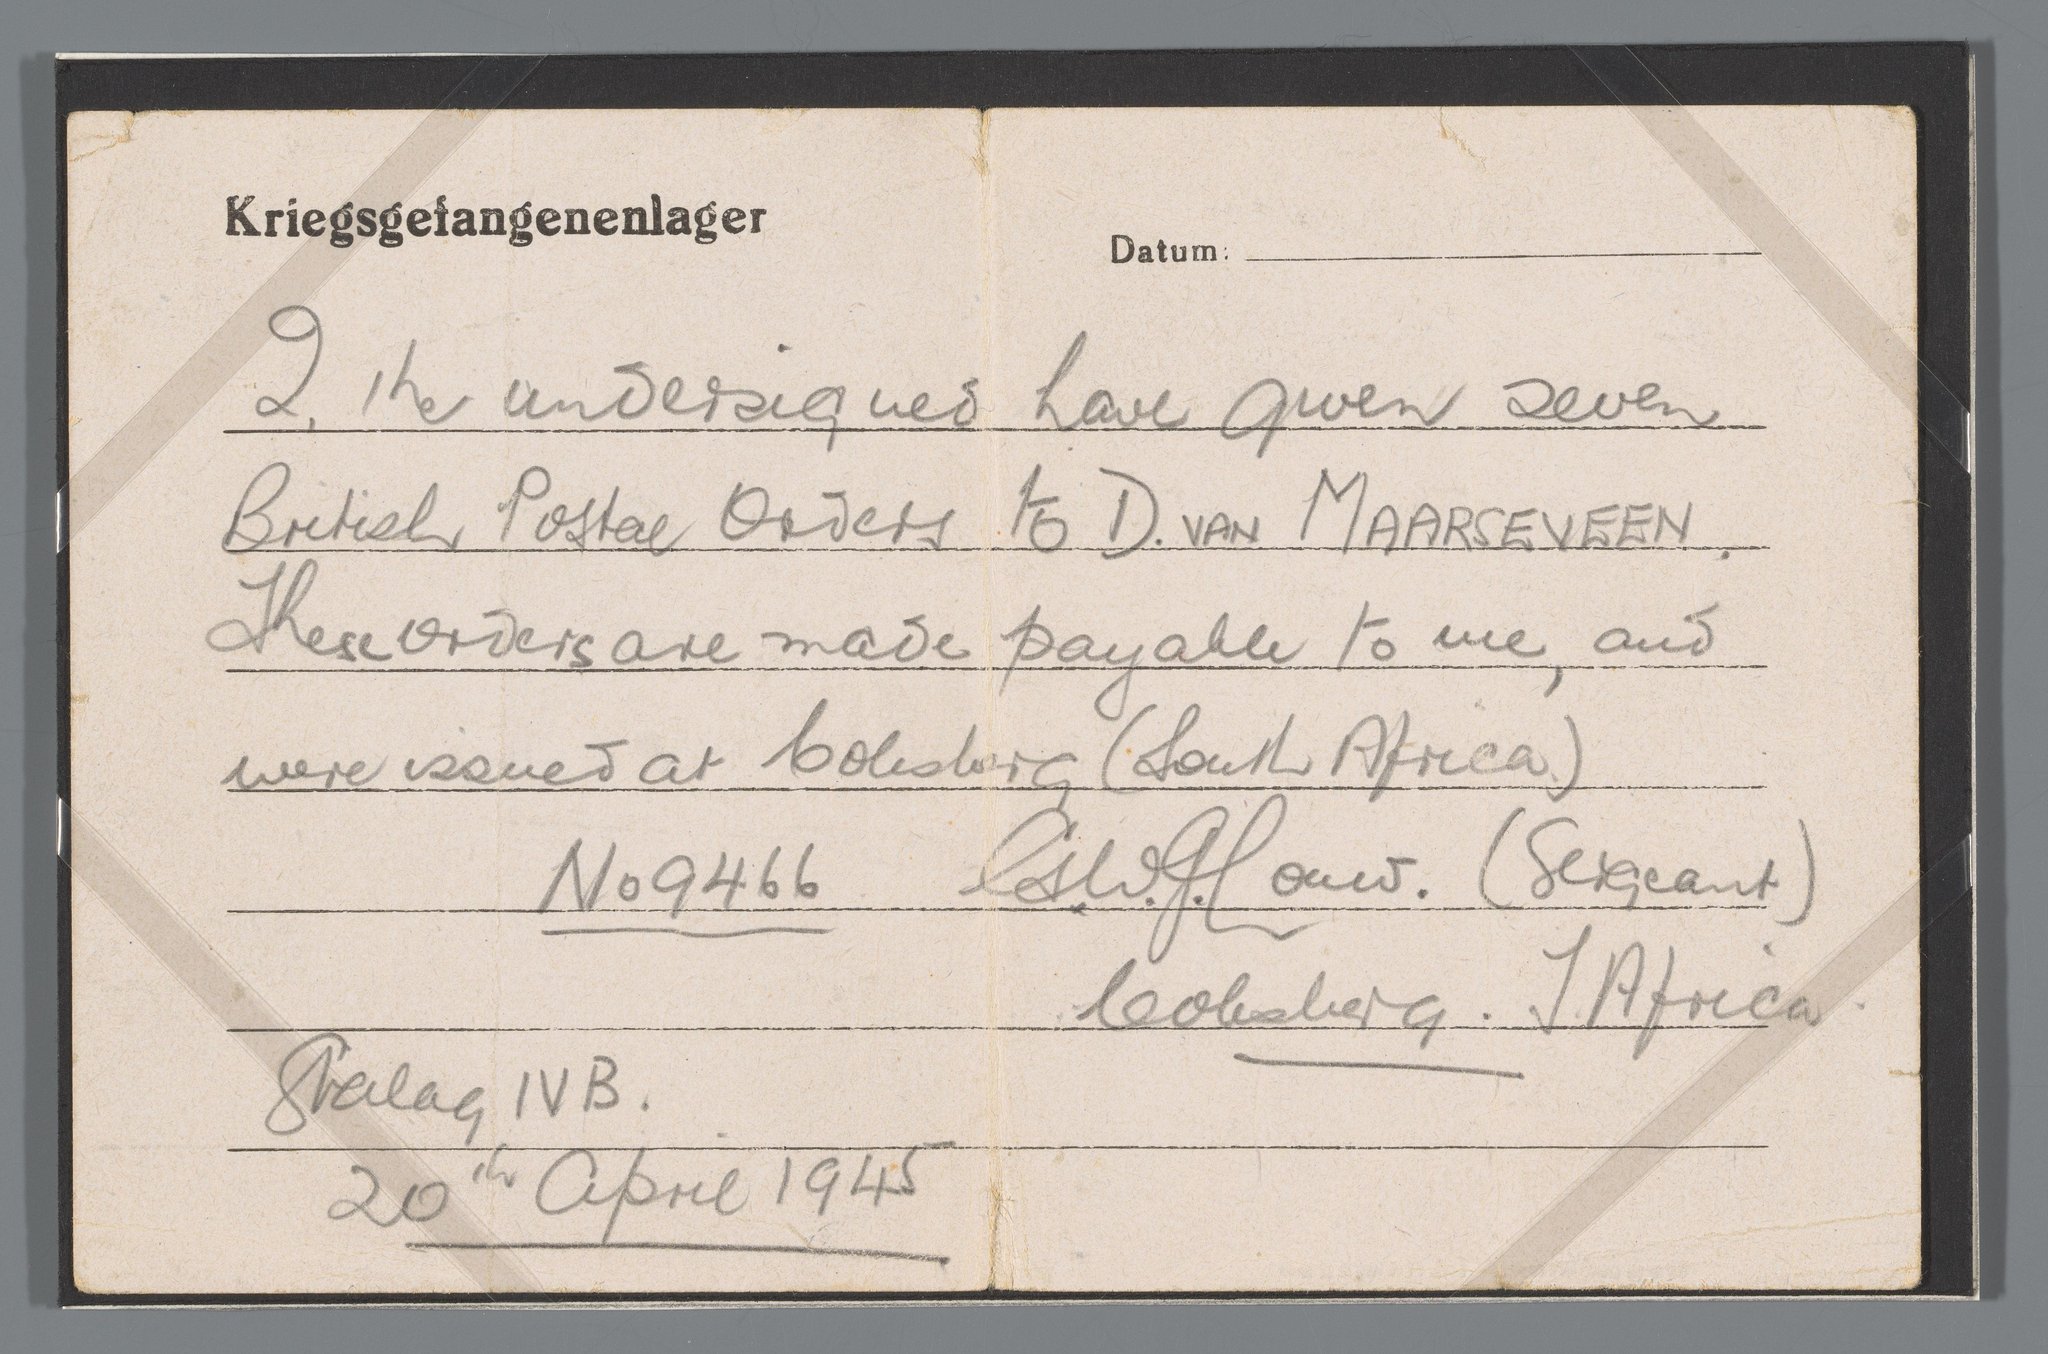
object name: postcard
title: Briefkaart uit krijgsgevangenenkamp Stalag IV B in Mühlberg a/d Elbe van sergeant D. van Maarseveen gebruikt als schuldbekentenis voor een lening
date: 1940-1945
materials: paper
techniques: printing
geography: muhlberg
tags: the hague, dick w.b. van maarseveen, prisoner of war camp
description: Helft van een bedrukte dubbelgevouwen postkaart waarop een Zuidafrikaanse sergeant verklaart zeven 'postal orders' te hebben gegeven aan D. van Maarseveen die aan hem kunnen worden uitbetaald. Gedateerd: Stalag IV B, 20 april 1945.